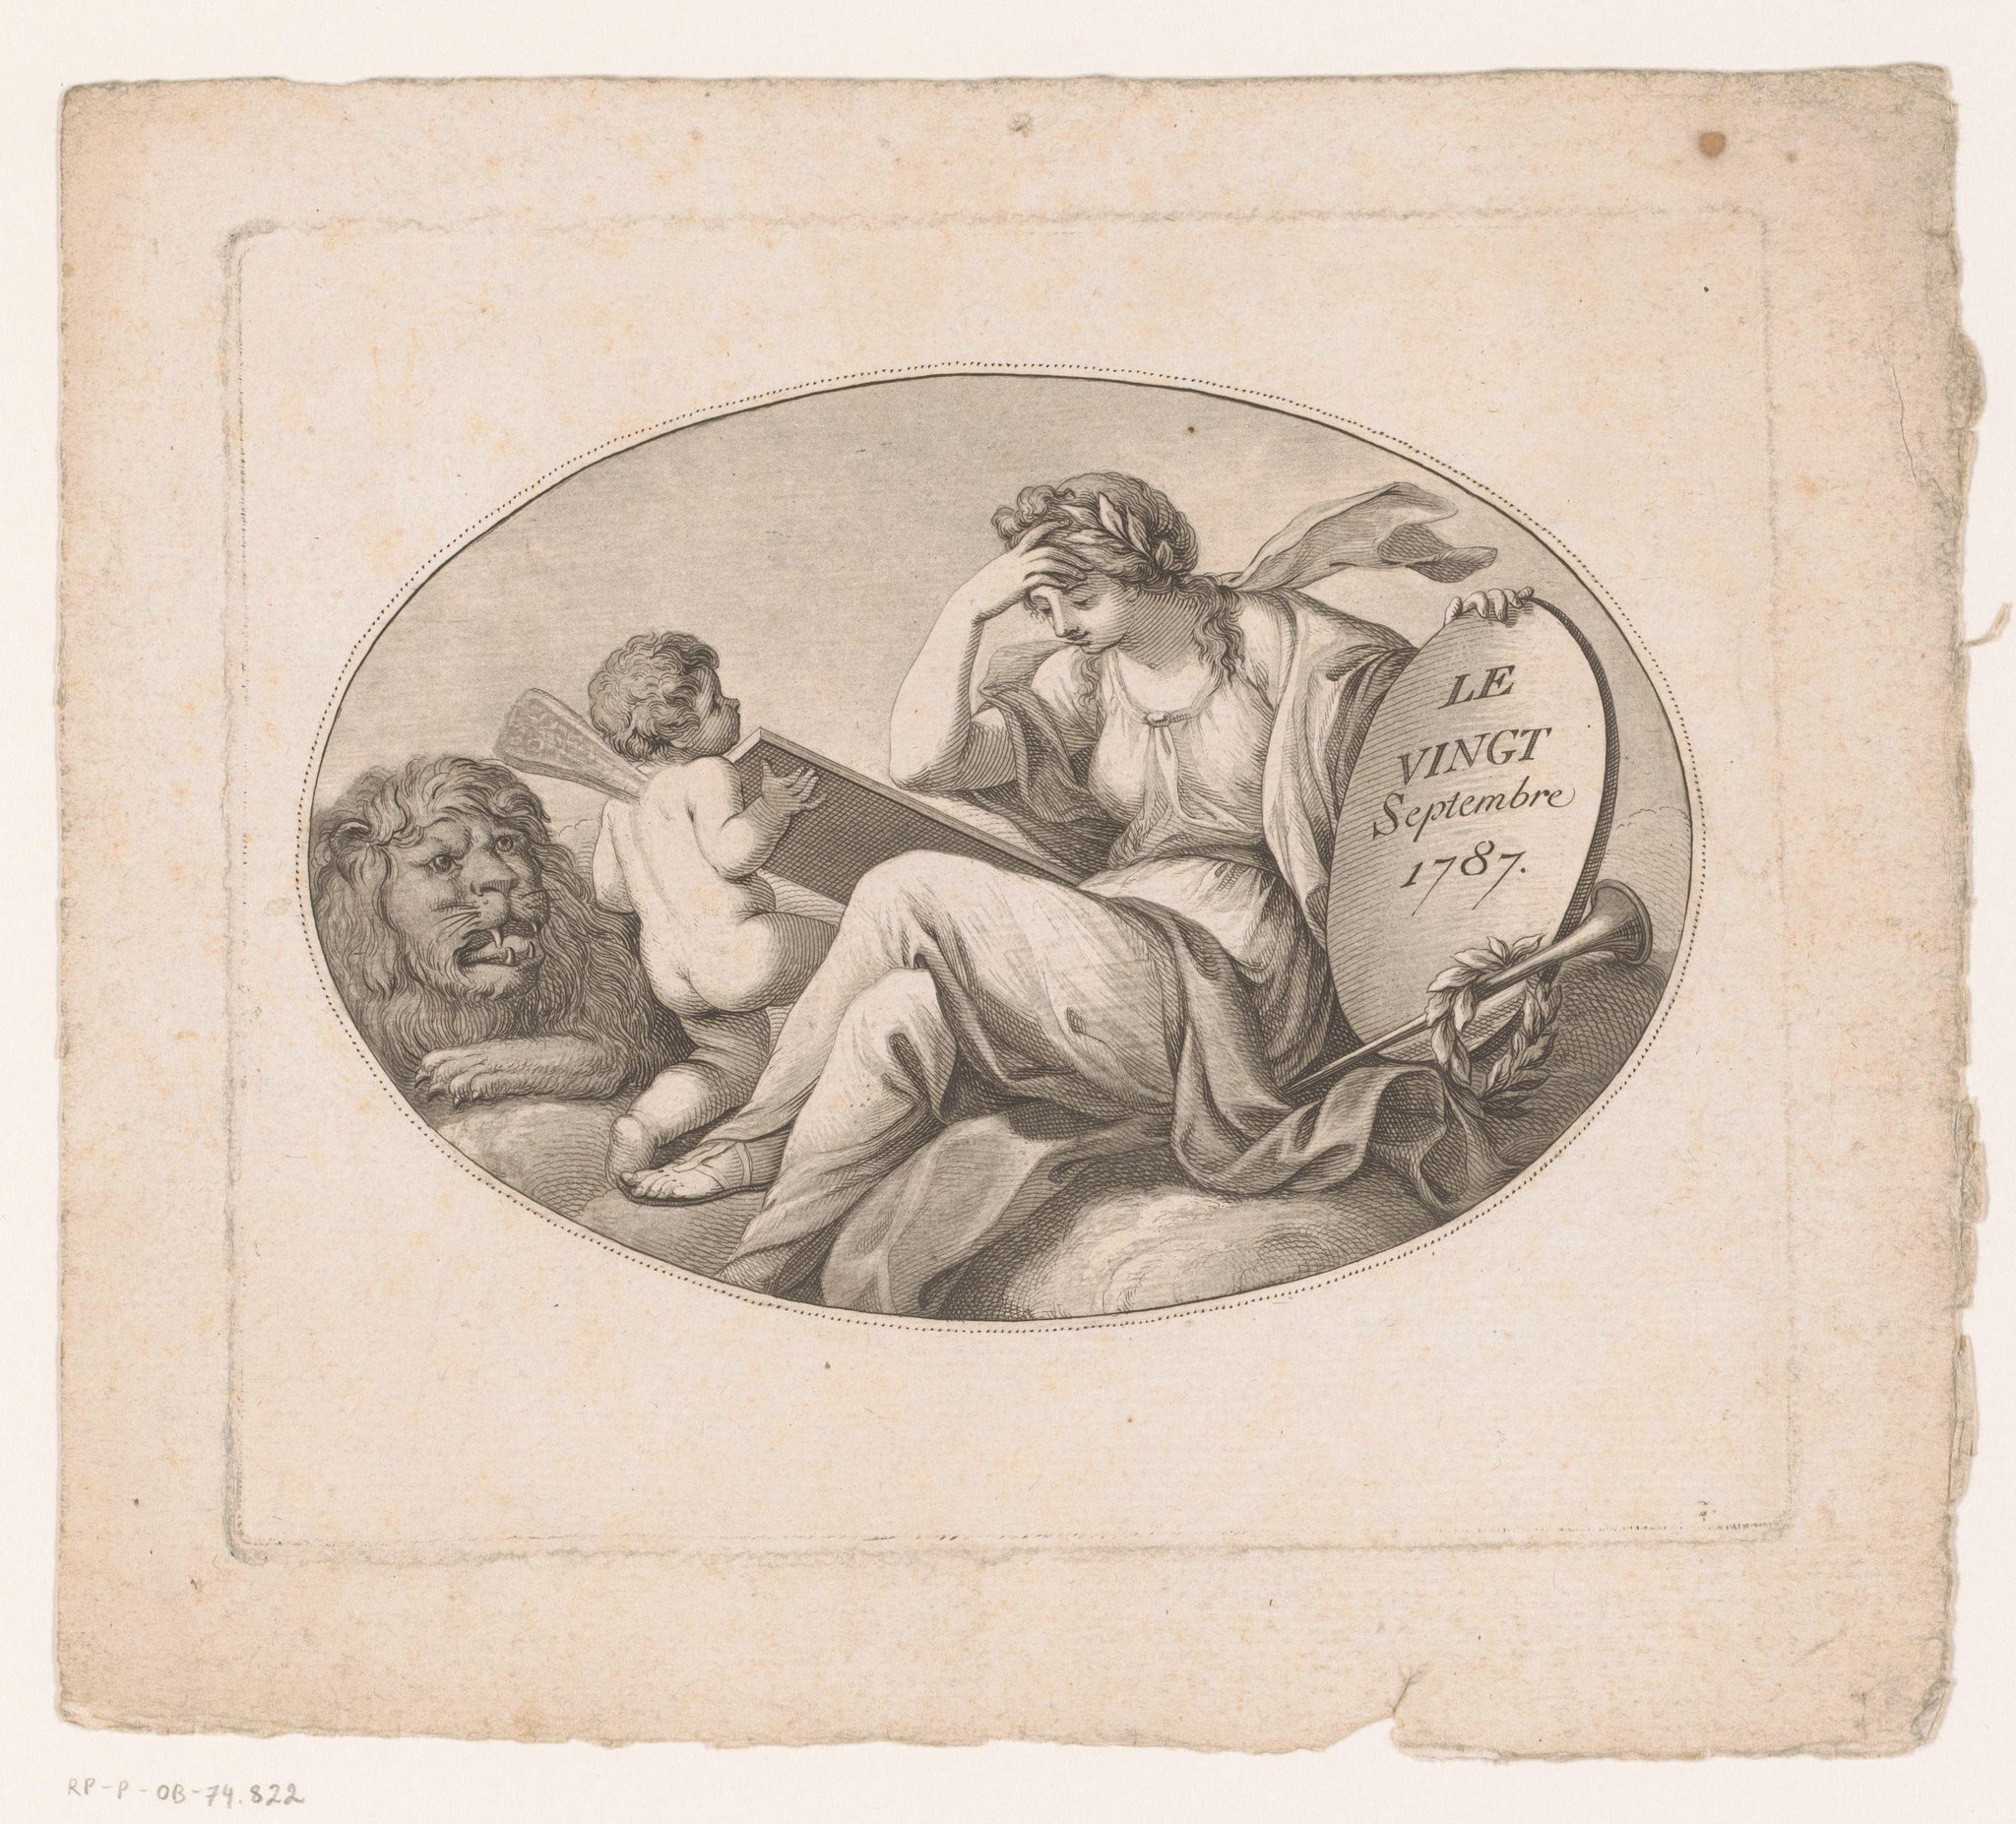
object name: print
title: Vrouw met putto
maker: Anonymous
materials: paper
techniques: aquatint, engraving, etching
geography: france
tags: adult woman, beasts of prey, predatory animals: lion - ff - fabulous animals (sometimes wrongly called 'grotesques'); 'mostri' (ripa), cupids: 'amores', 'amoretti', 'putti'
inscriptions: collector's mark: Lugt 2228